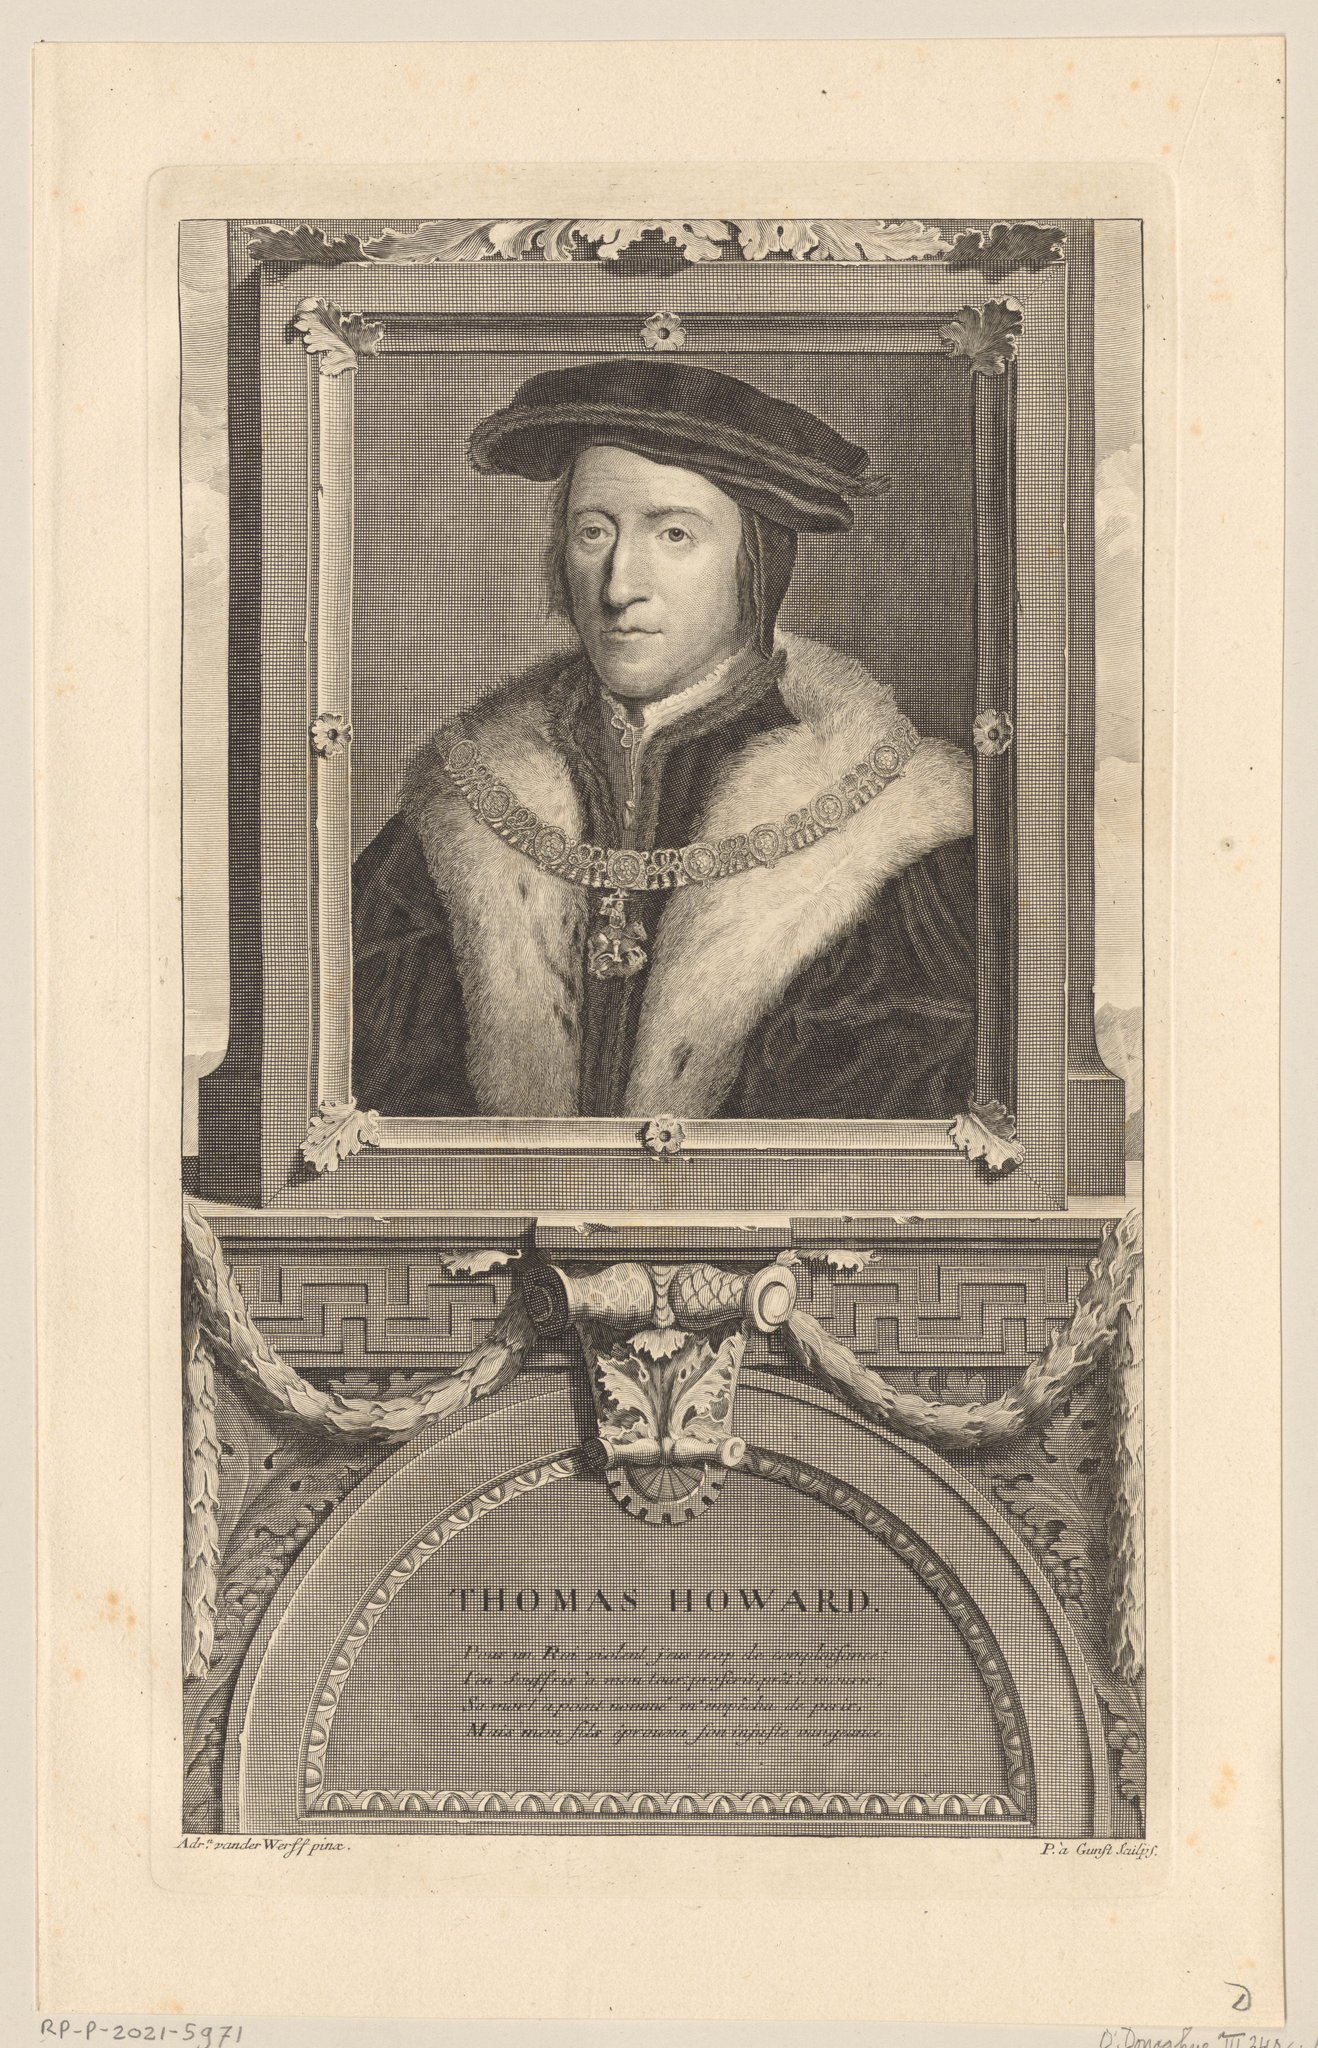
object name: print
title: Portret van Thomas Howard, 3e graaf van Norfolk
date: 1697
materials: paper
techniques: engraving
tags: politician, historical persons, politician, e.g. party leader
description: Prent mogelijk uit: Larrey, Isaac de. Histoire d'Angleterre, d'Écosse et d'Irlande (...). Rotterdam: Reinier Leers, 1697, dl. 2.